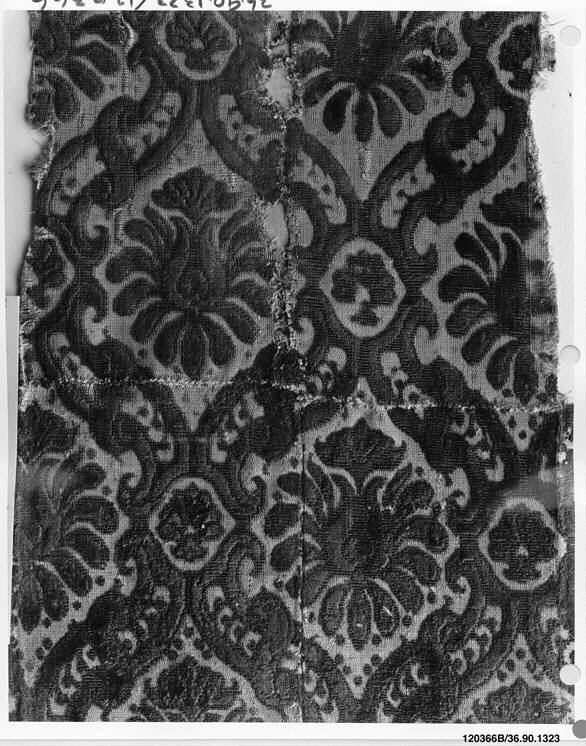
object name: piece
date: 1501-1700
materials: silk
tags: flowers